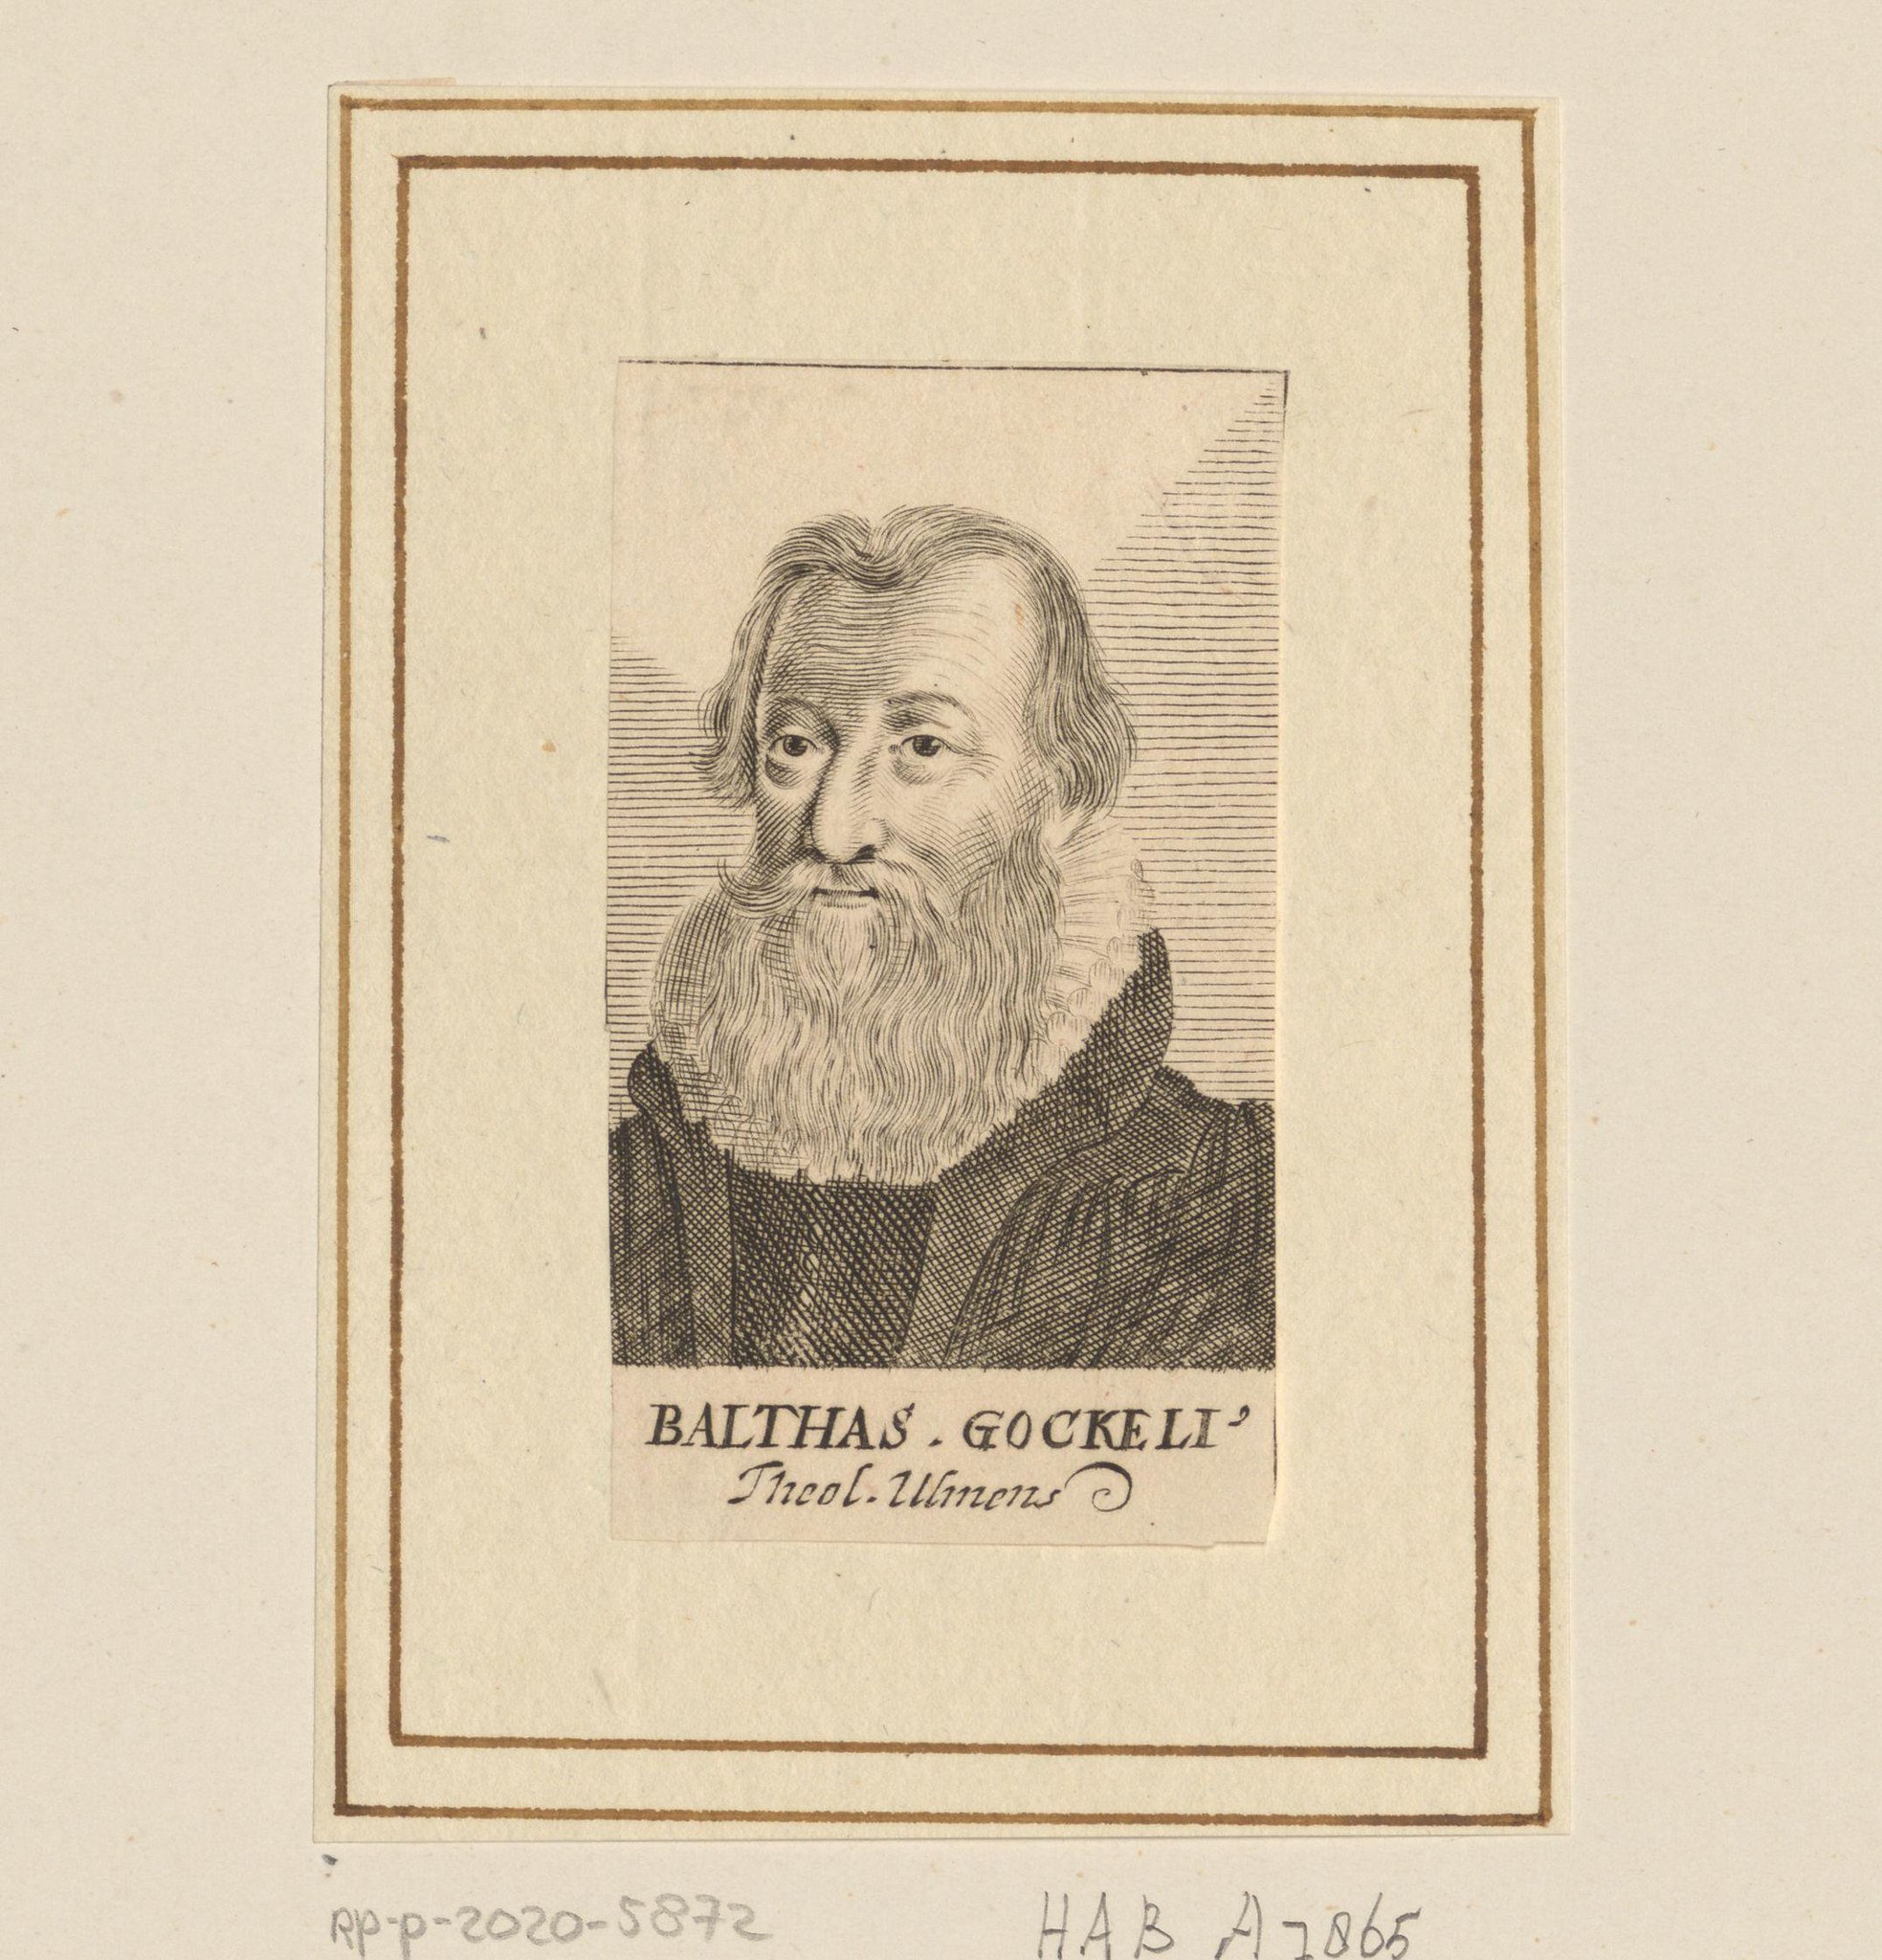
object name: print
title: Portret van Balthasar Gockel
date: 1688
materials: paper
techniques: engraving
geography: nuremberg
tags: historical persons, portrait of a writer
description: Prent uit: Freher, Paul. Theatrum virorum eruditione clarorum. Neurenberg: Johann Hoffmann, 1688.